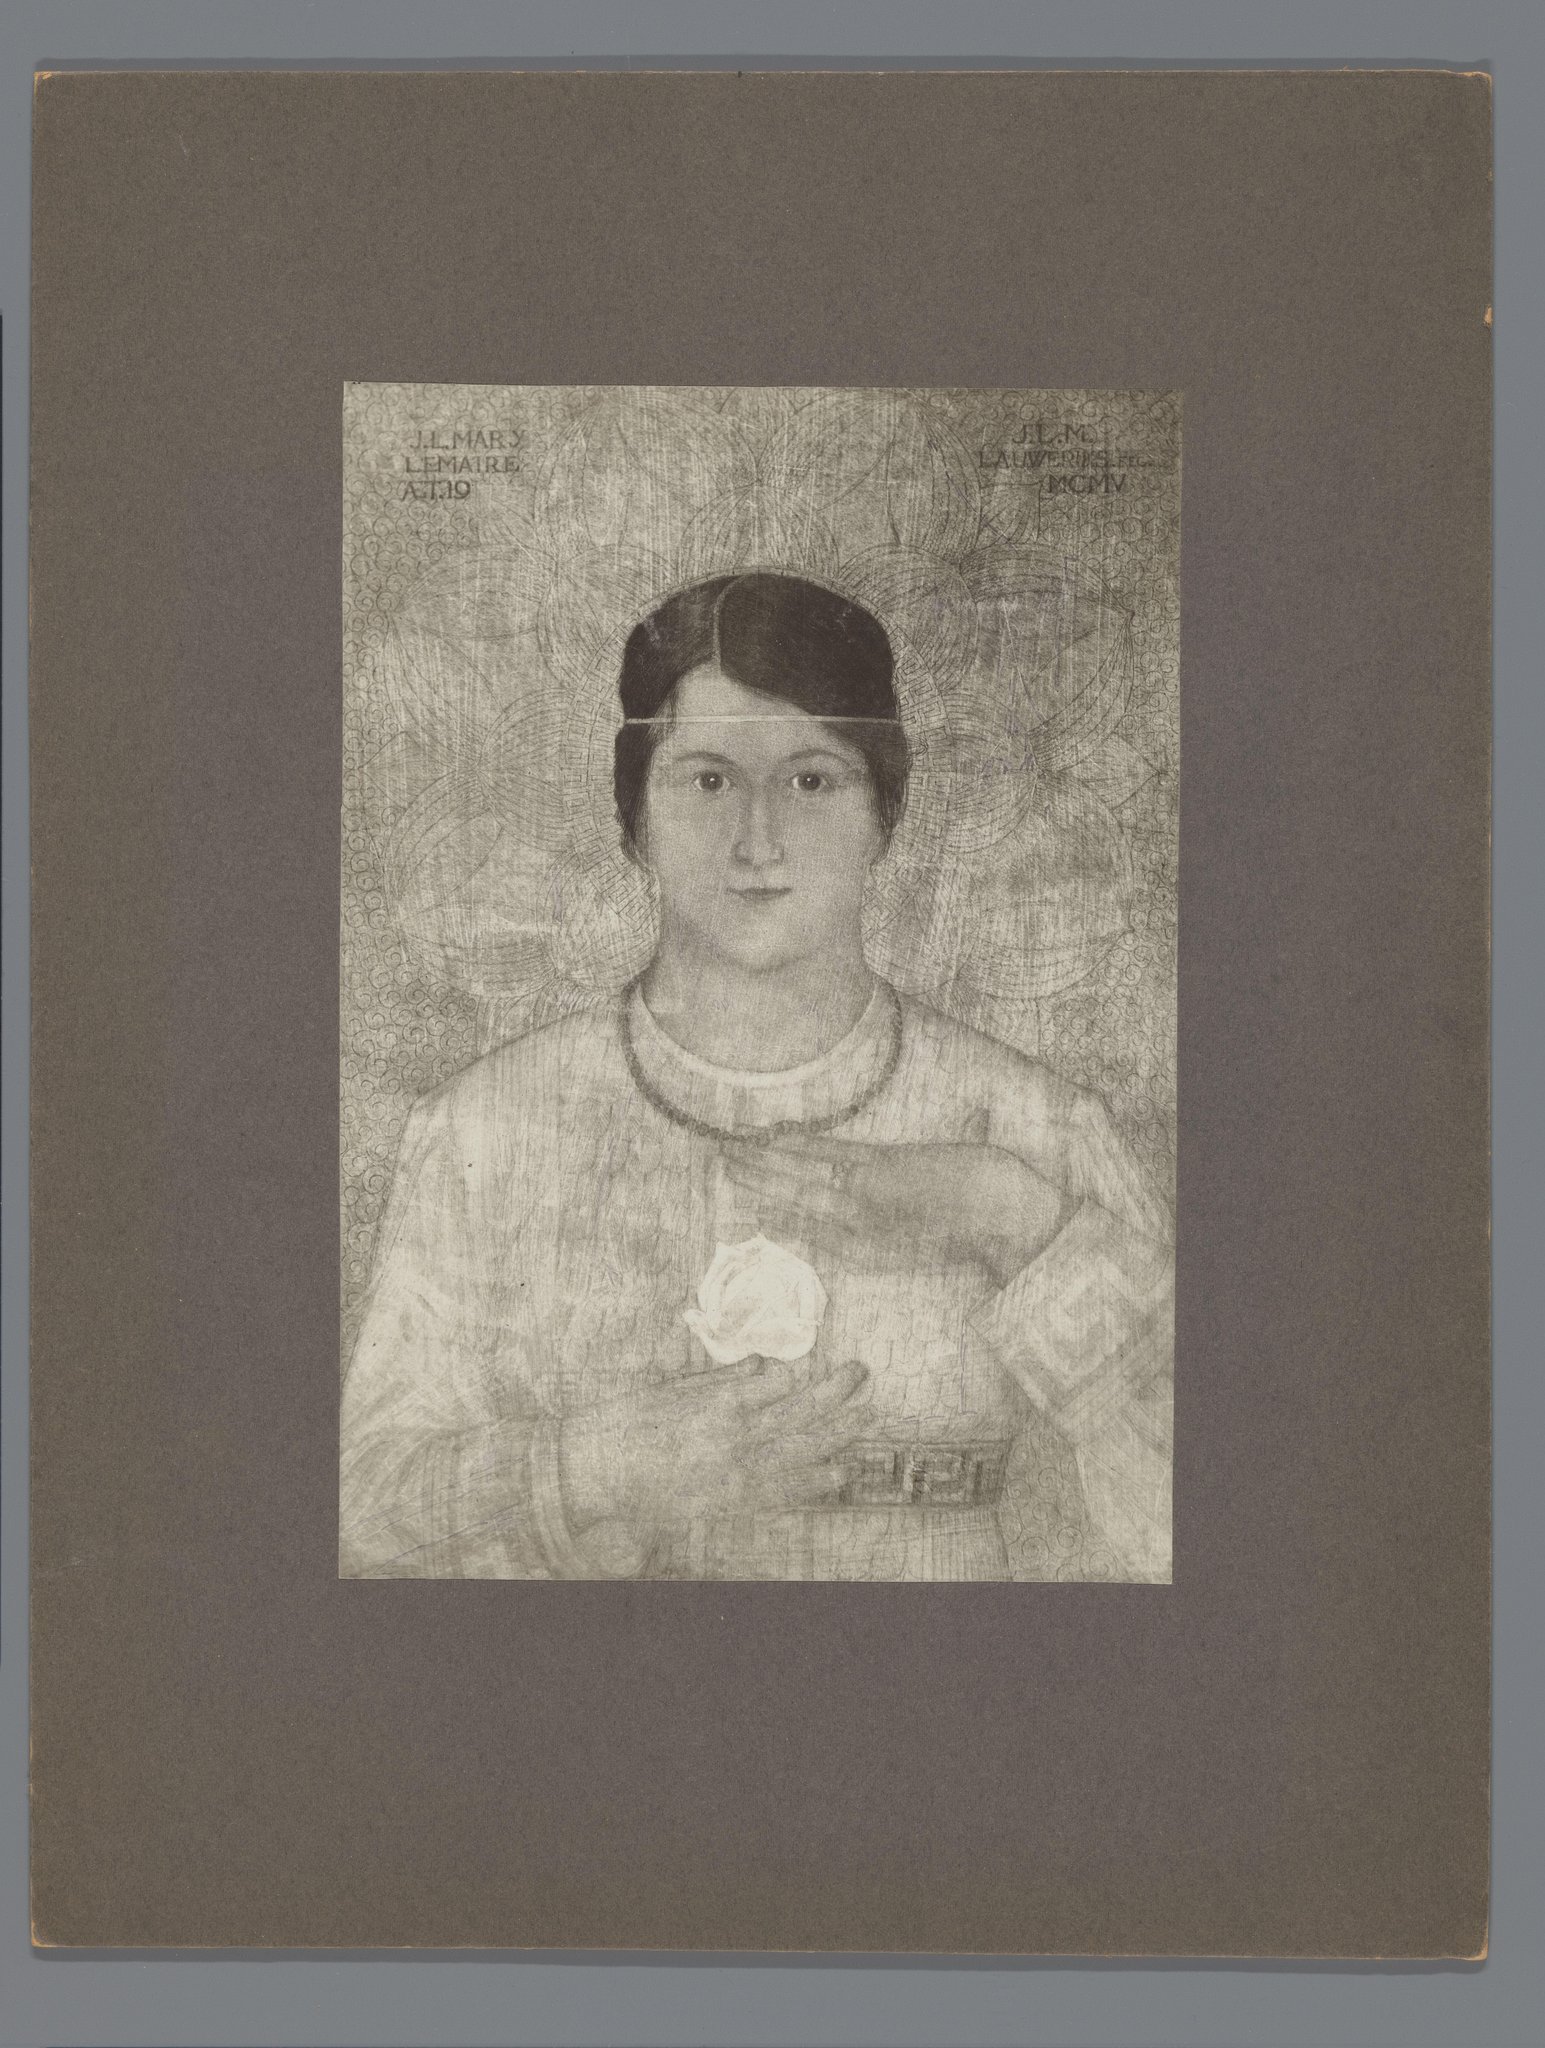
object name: reproduction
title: Fotoreproductie van een getekend portret van een vrouw door Mathieu Lauweriks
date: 1910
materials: cardboard, photographic support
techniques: gelatin silver print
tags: adult woman, historical persons - bb - woman